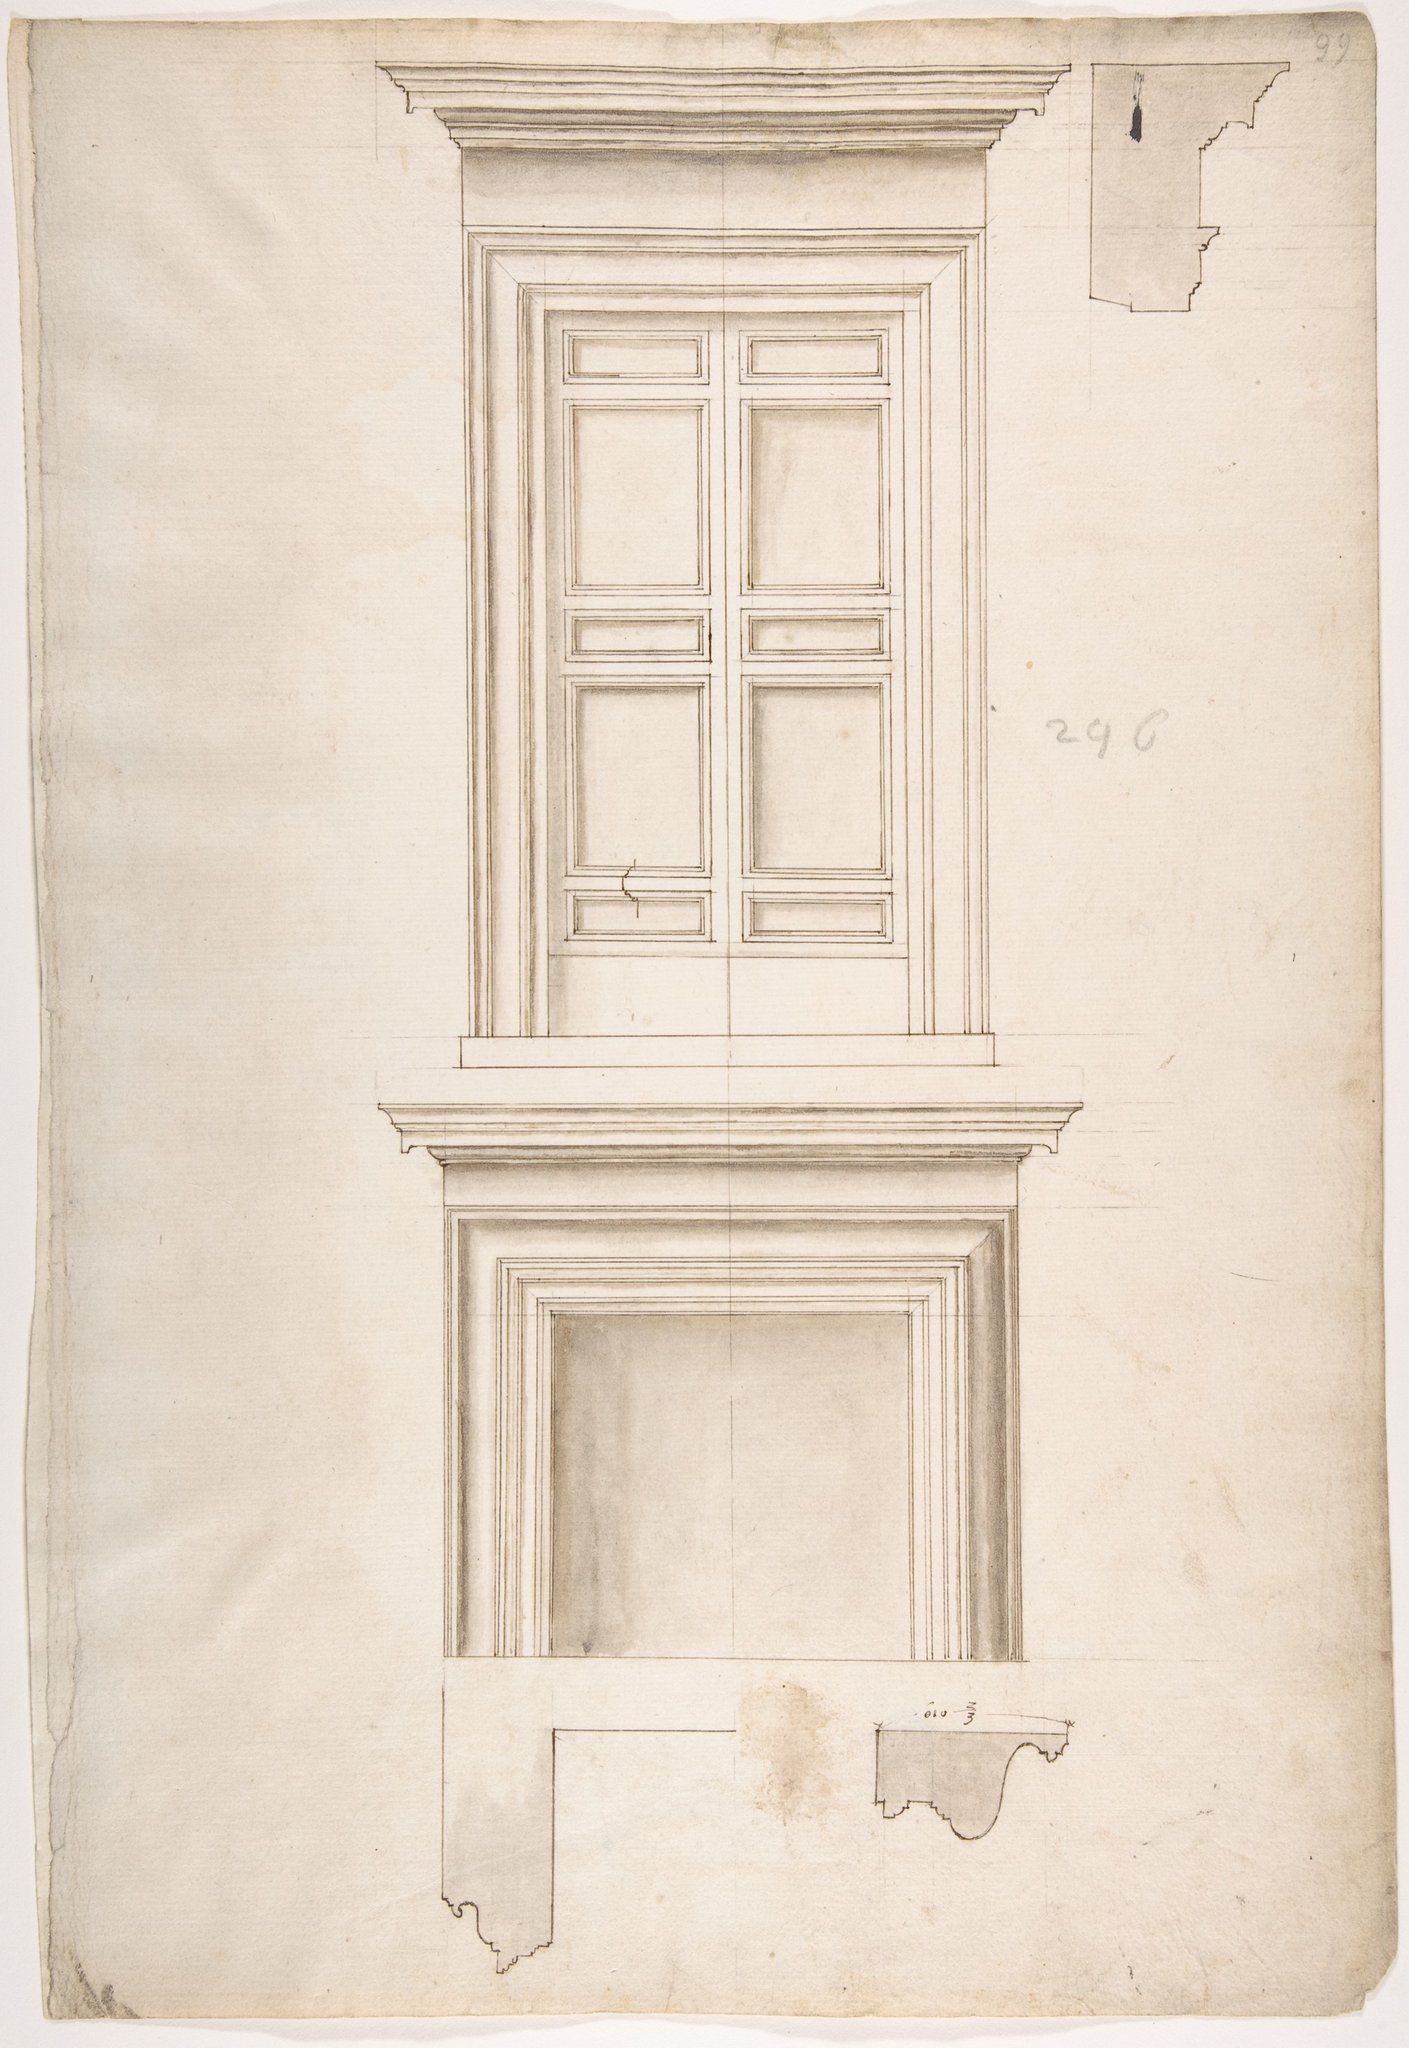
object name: drawing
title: Unidentified, portal, elevation; portal, cornice, profile; fireplace, elevation (recto) blank (verso)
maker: anonymous, french, 16th century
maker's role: draftsman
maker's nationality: french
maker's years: 1500-1600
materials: chalk, ink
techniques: incising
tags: architecture